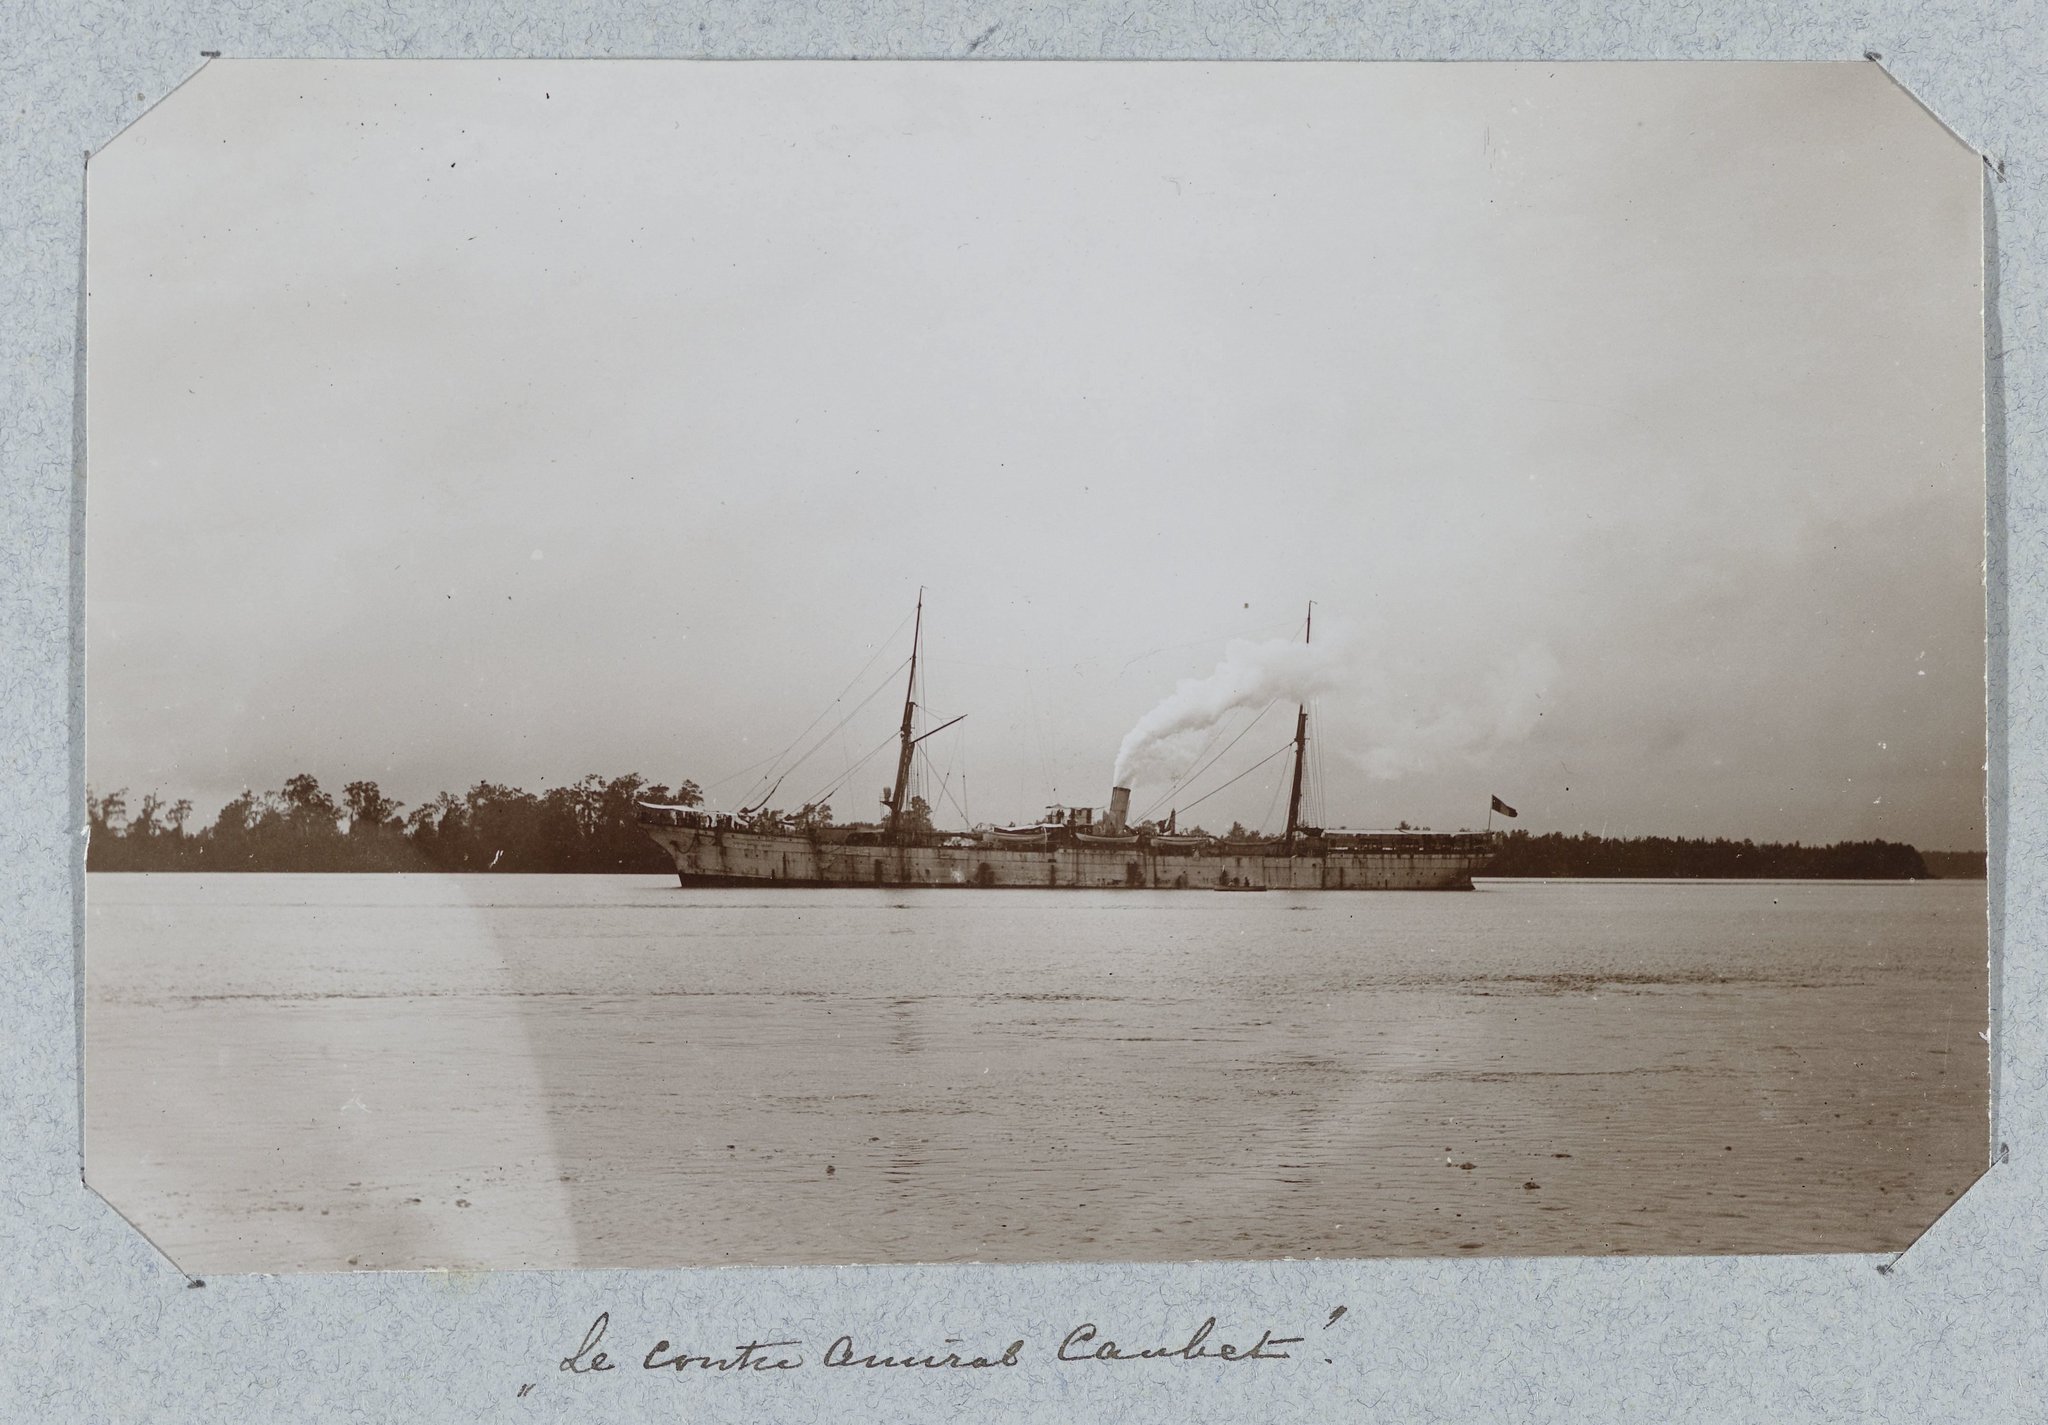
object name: photograph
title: "Le contre Amiral Courbet"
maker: théodore van lelyveld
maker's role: painter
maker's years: 1867-1954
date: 1895-1898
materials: photographic support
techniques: collodion silver print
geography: suriname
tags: sailing-ship, sailing-boat, steamship, motorship, suriname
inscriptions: inscription: ‘"Le contre Amiral Courbet".’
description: Het Franse schip genaamd "Le contre Amiral Courbet" varend over een rivier. Fotoafdruk in een fotoalbum van Théodore van Lelyveld over Suriname uit 1895-1898.